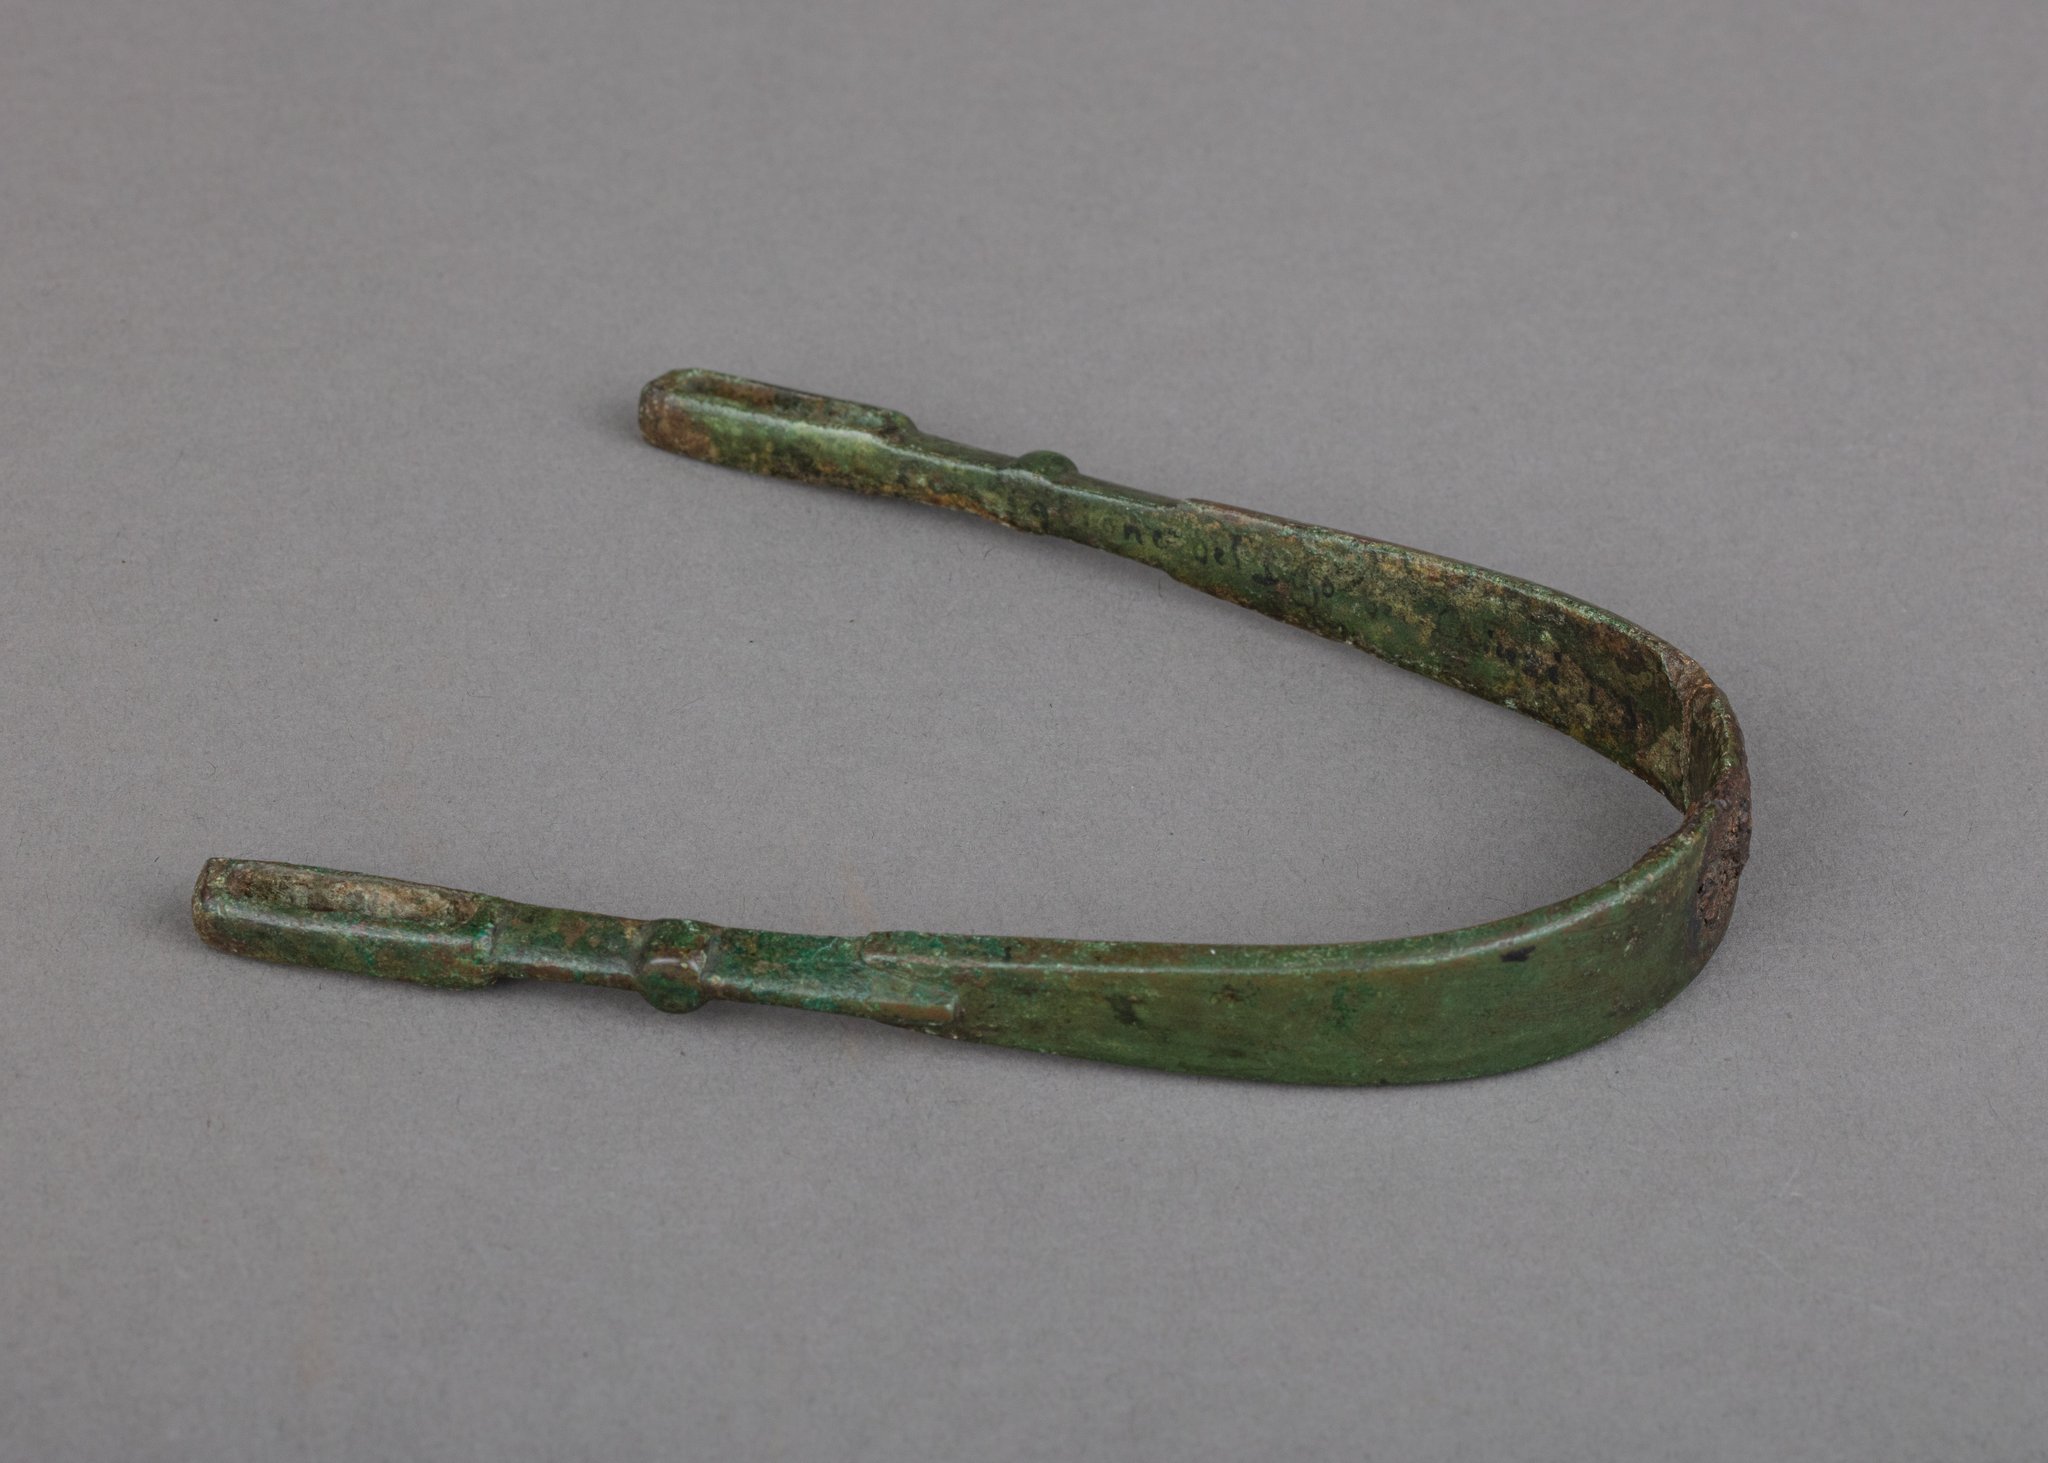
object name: spur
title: Prick Spur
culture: longobardic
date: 501-700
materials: copper alloy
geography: italy